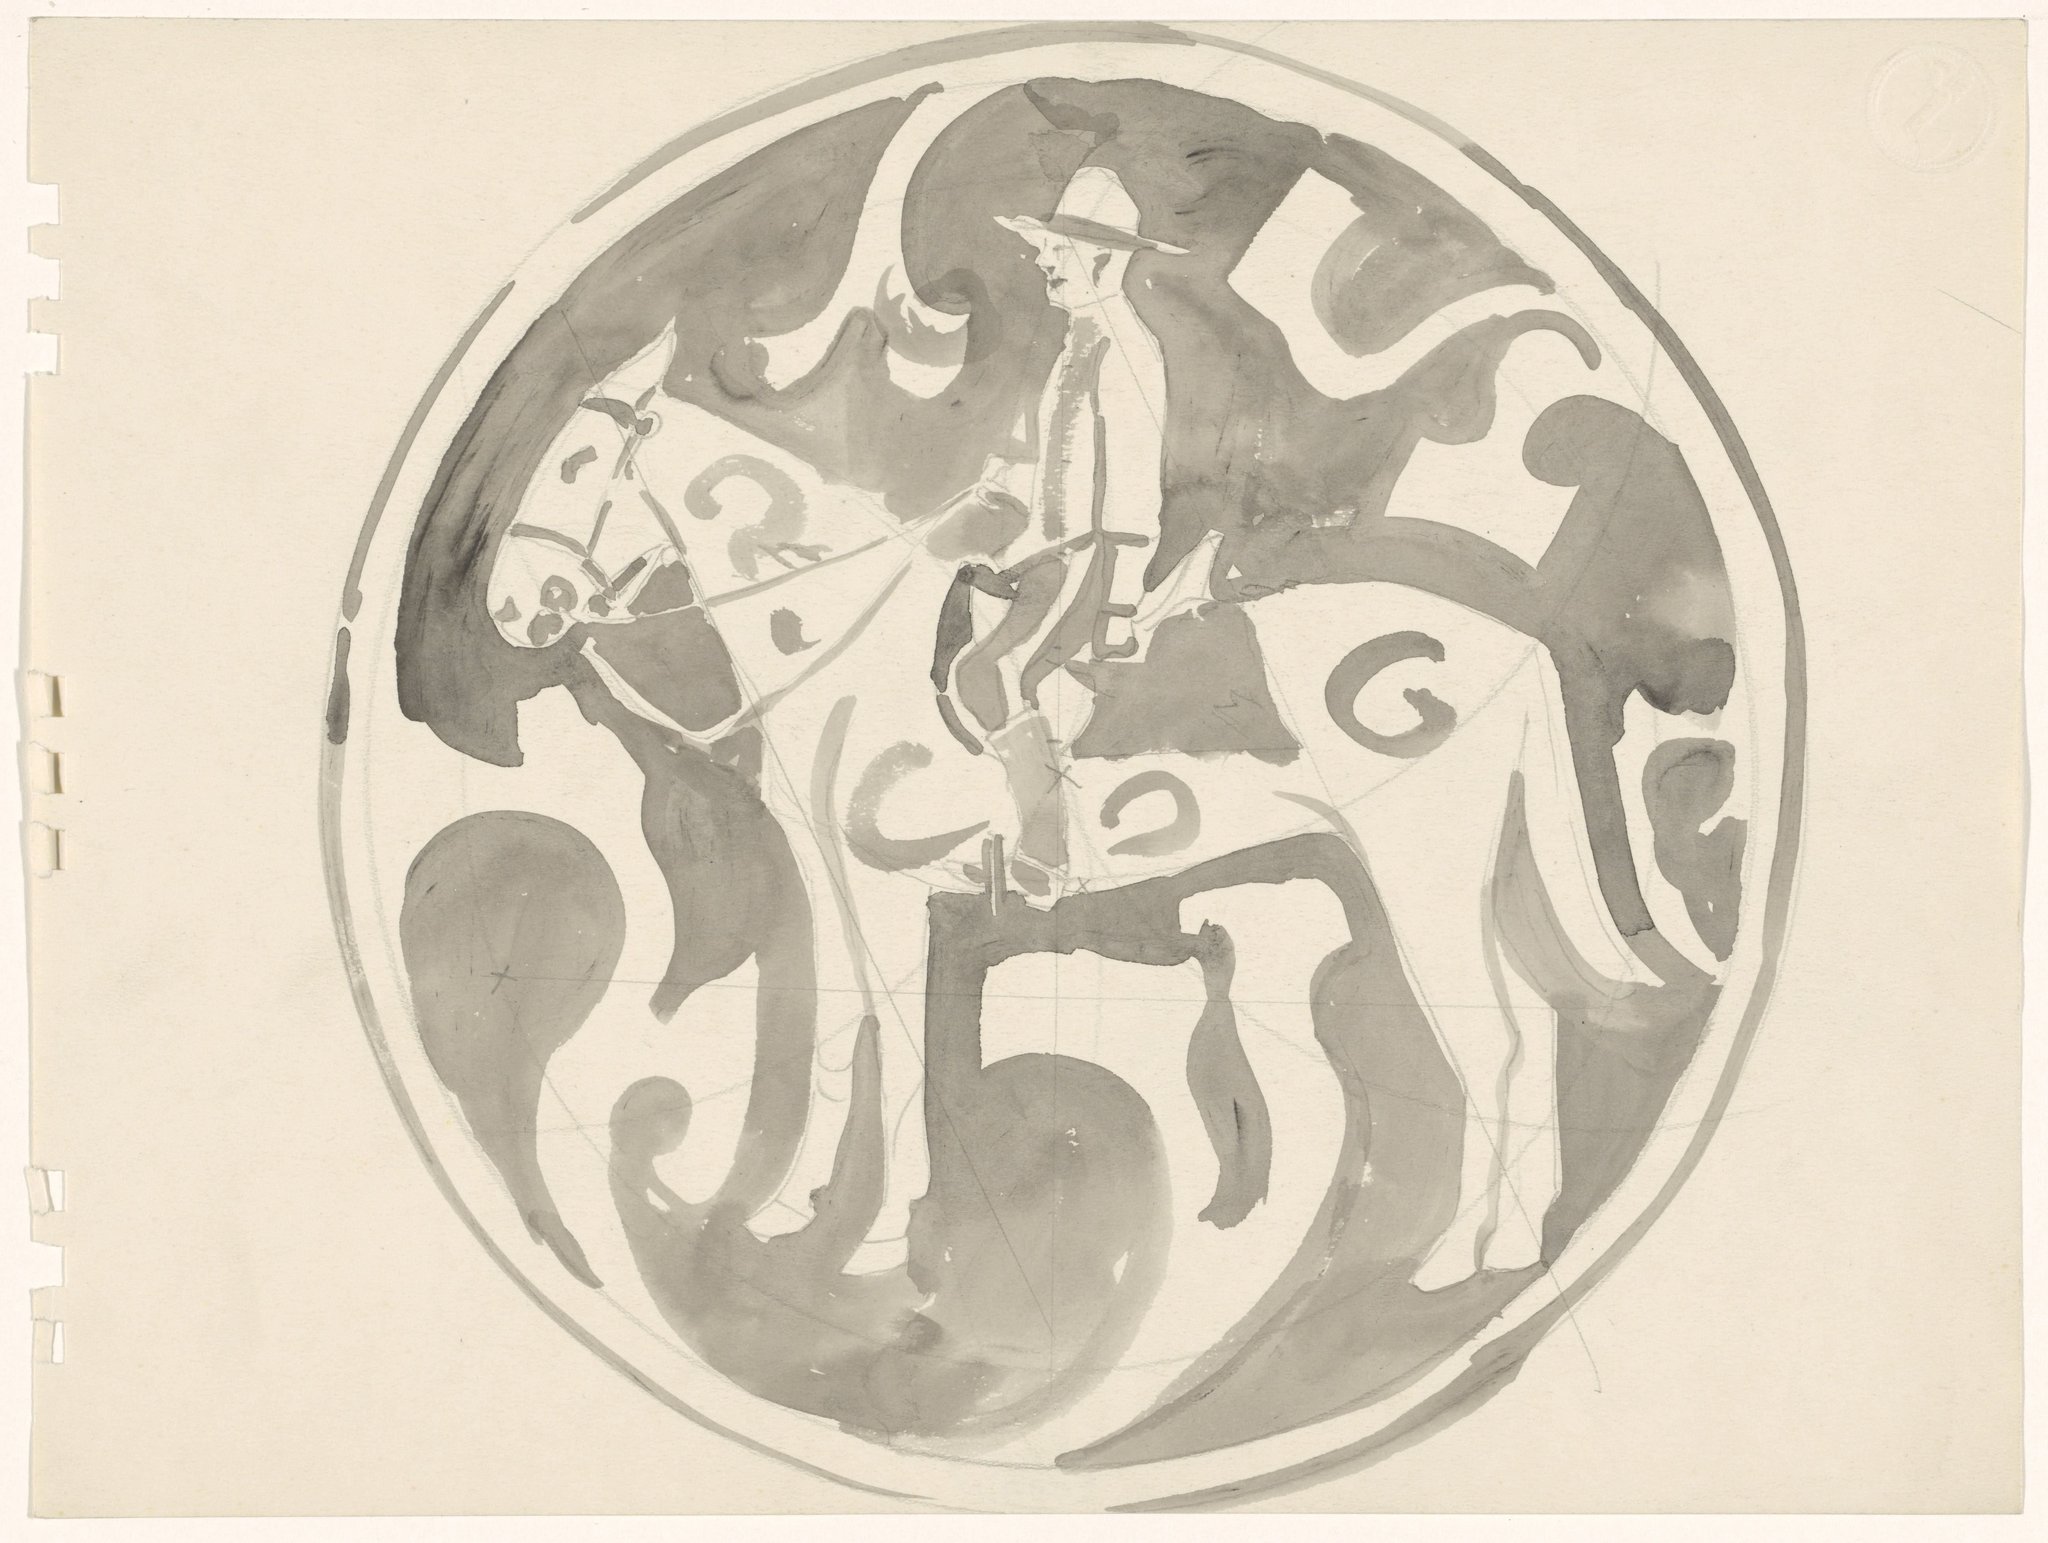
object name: design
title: Ontwerp voor een bord met een Canadese mountie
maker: carel adolph lion cachet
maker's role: draughtsman, print maker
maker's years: 1864-1945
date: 1874-1945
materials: paper, pencil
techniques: brush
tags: work of applied art (+ ceramics ~ arts), dish, plate, saucer